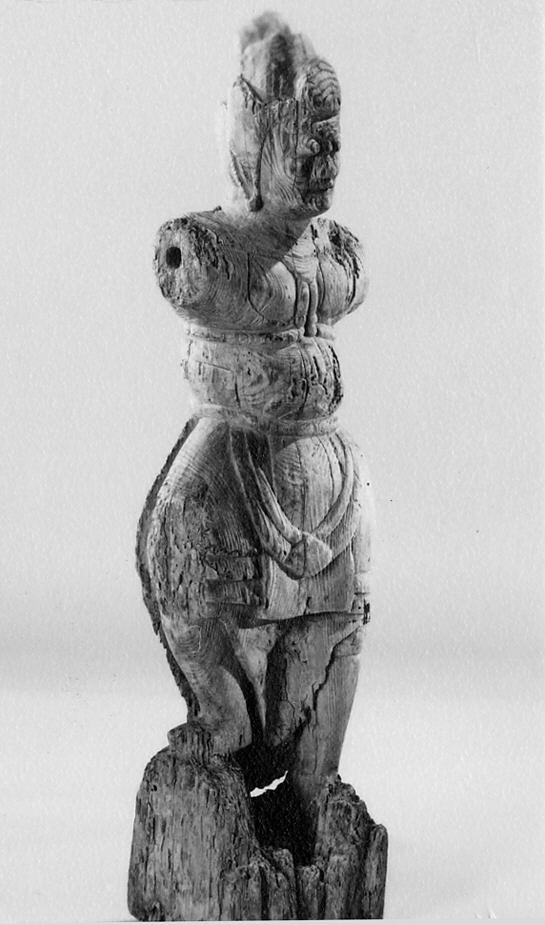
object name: figure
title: One of the Four Heavenly Kings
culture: japanese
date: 1067-1133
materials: wood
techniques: painting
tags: kings,buddhism